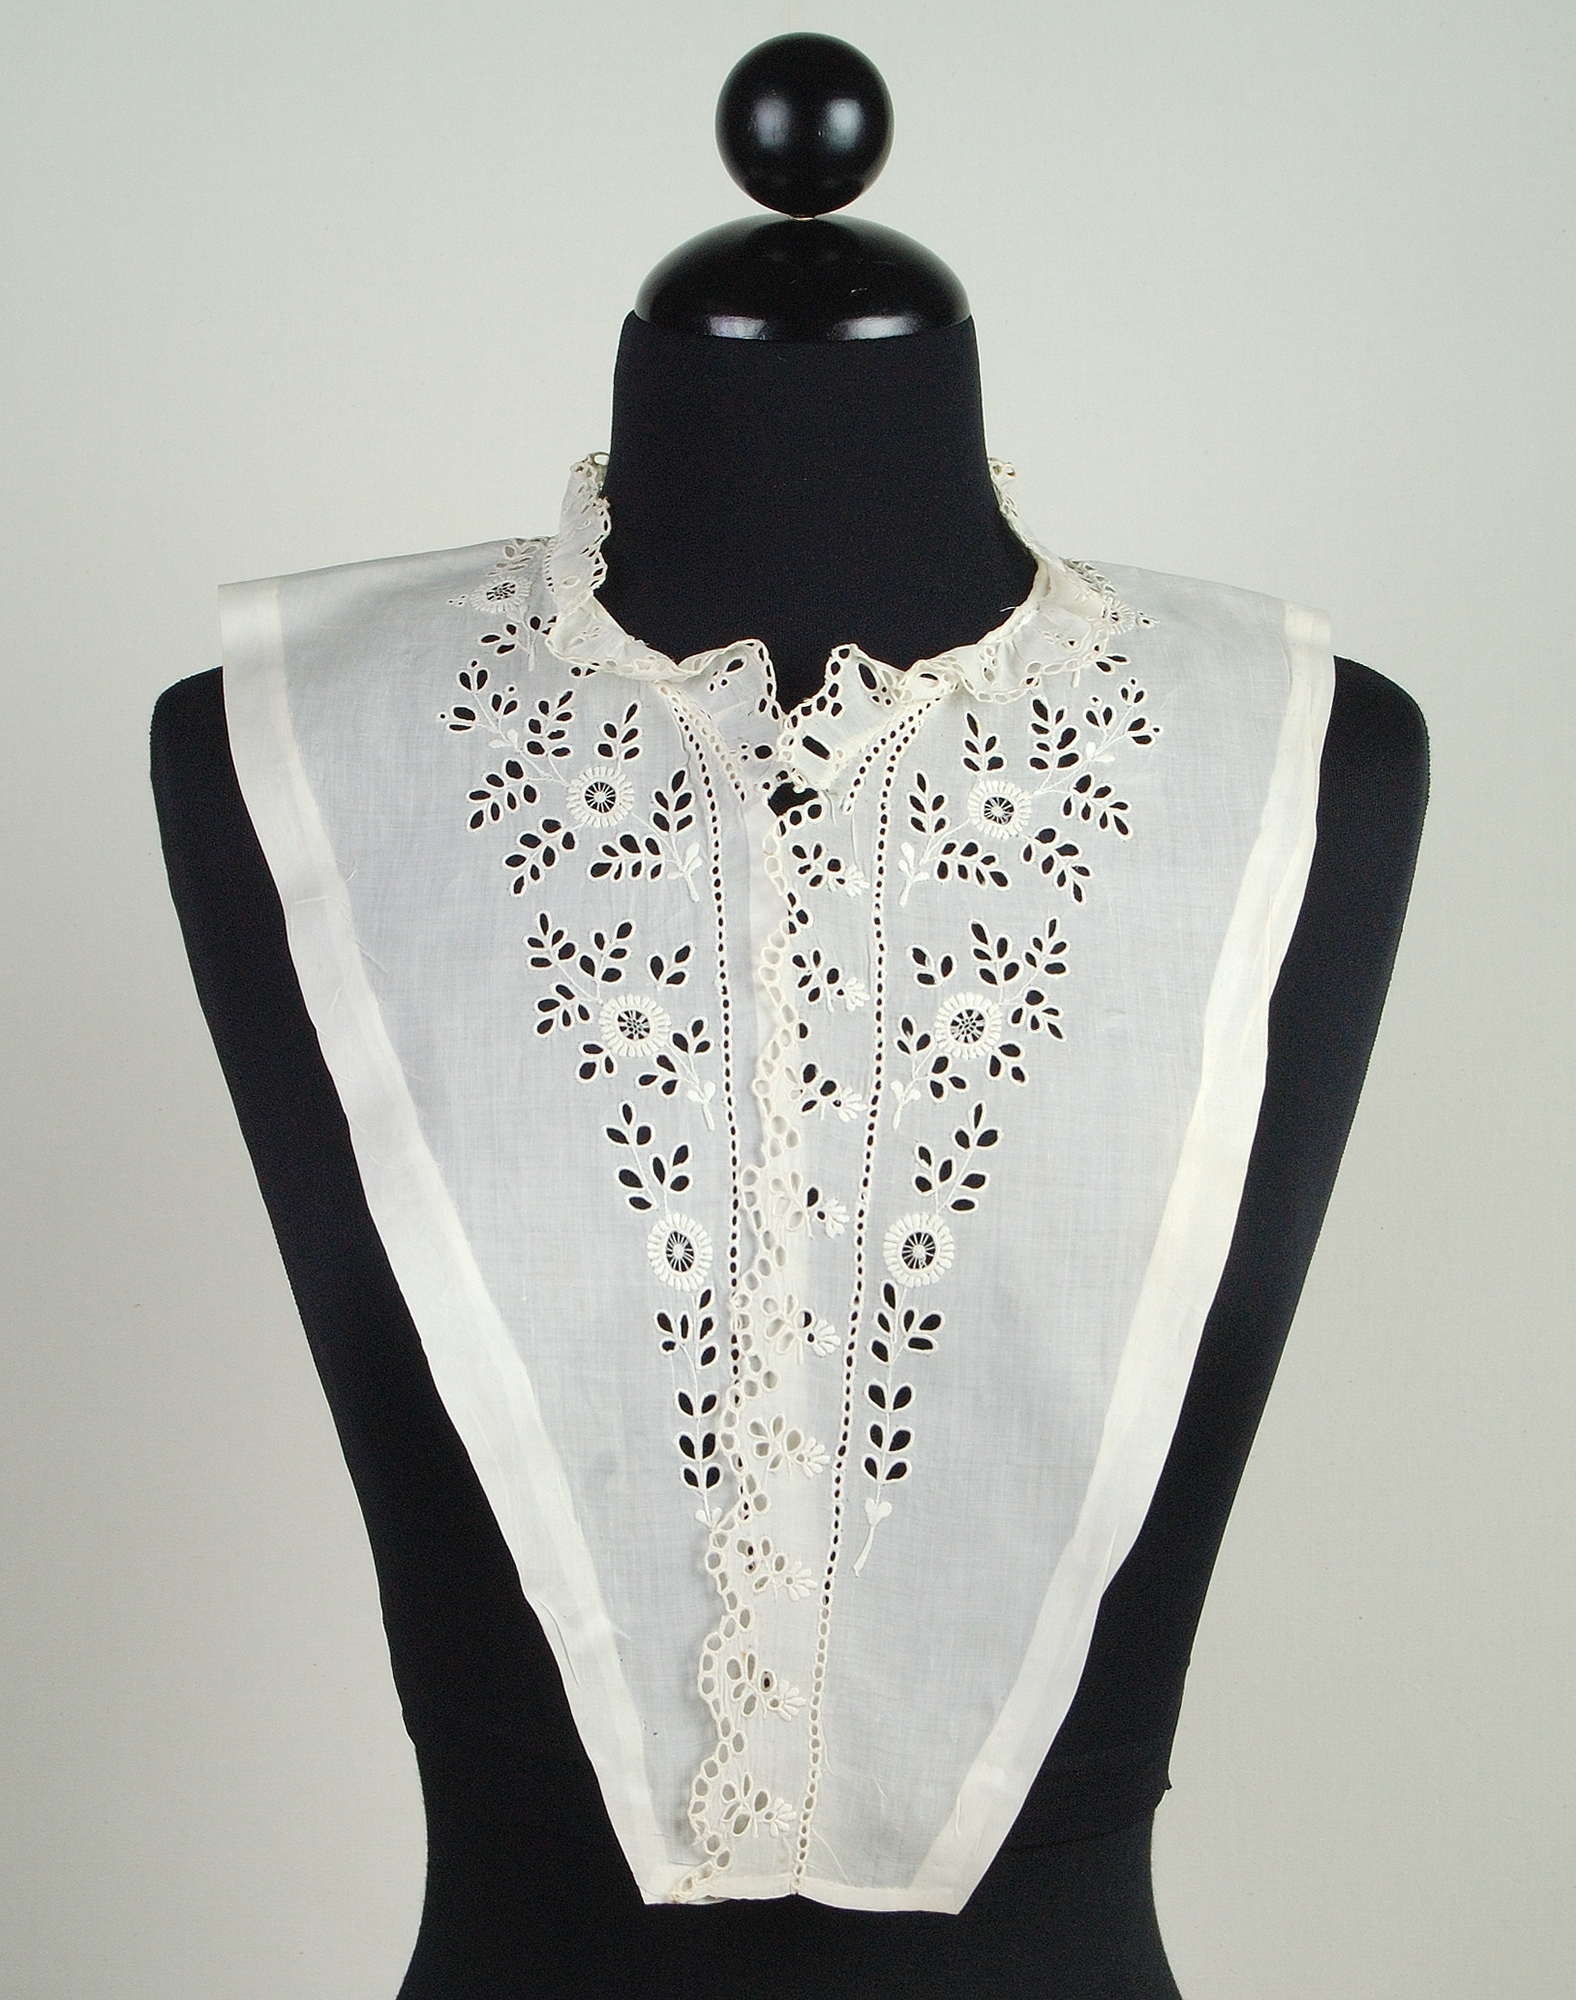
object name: chemise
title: Chemisette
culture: american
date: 1860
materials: linen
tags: flowers